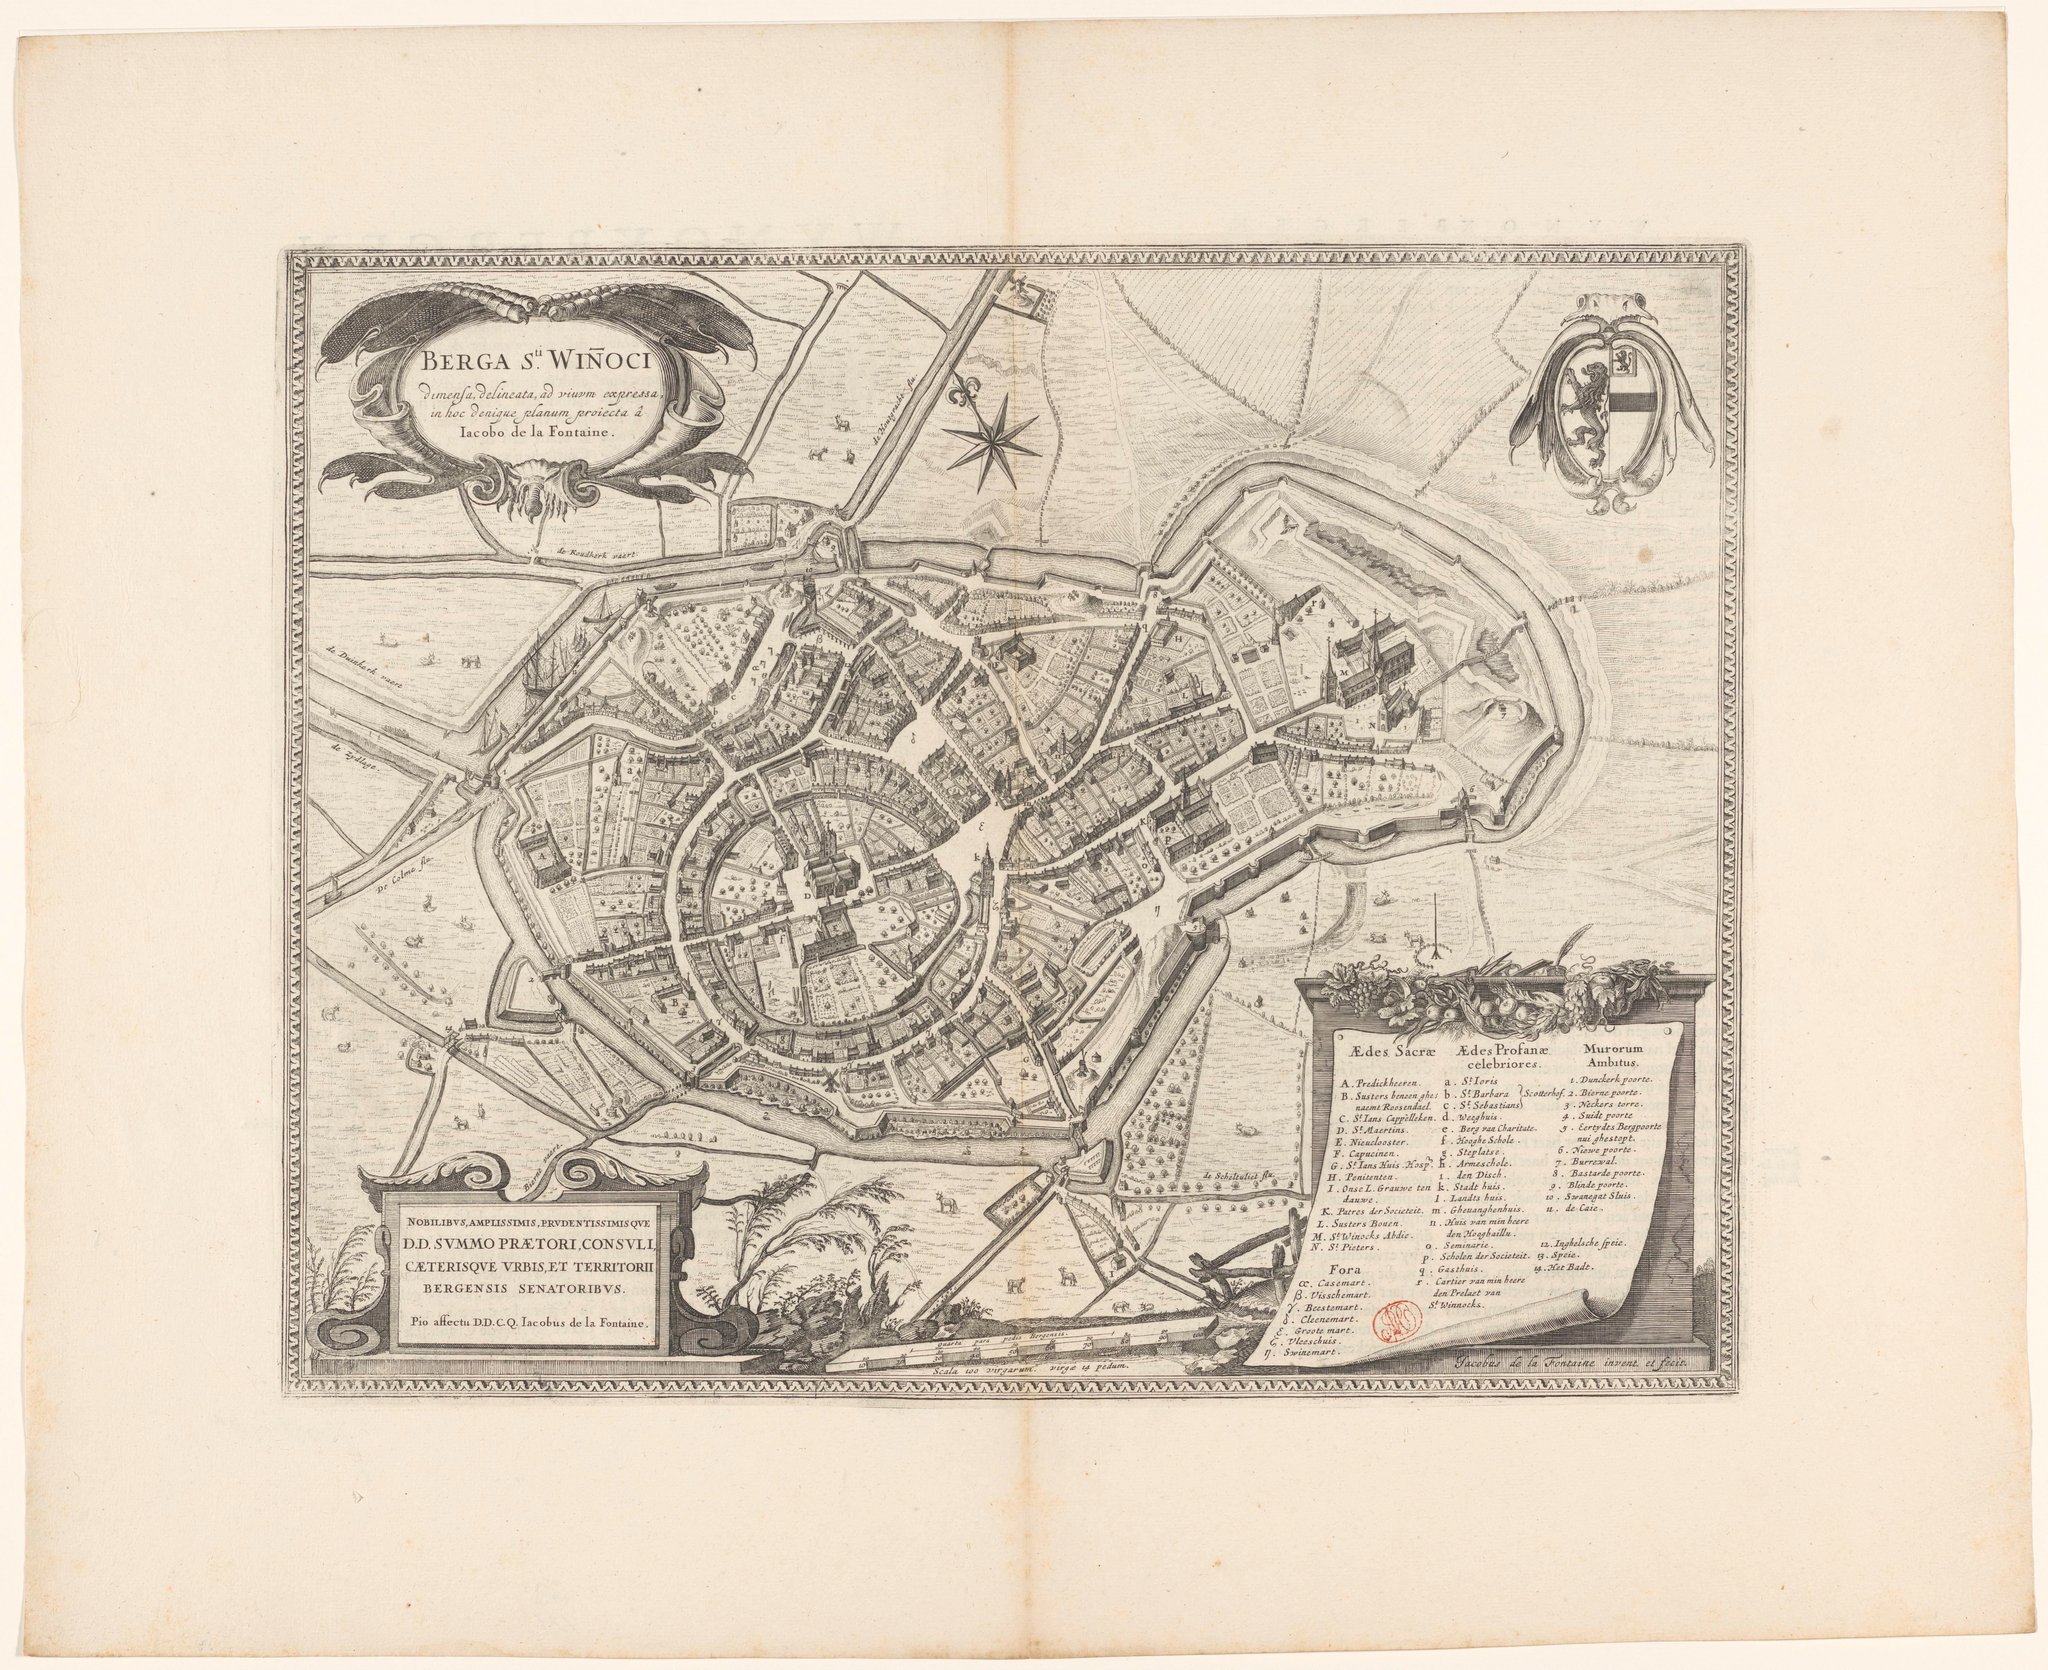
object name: print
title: Plattegrond van Sint-Winoksbergen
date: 1652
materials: paper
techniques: engraving, etching, letterpress printing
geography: sint-winoksbergen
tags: maps of separate countries or regions, coat of arms (as symbol of the state, etc.) (+ province; provincial)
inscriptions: collector's mark: Lugt 195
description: Plattegrond van Sint-Winoksbergen, ook wel Bergen genoemd, met gebouwen in vogelvluchtperspectief. Linksboven de titelcartouche. Rechtsboven het wapen van Sint-Winoksbergen. Linksonder een cartouche met opdracht. Rechtsonder een uitgebreide legenda in de vorm van een blad papier. Onder, in het midden, twee schaalstokken: Quarta pars pedis Bergensis / Scala 100 virgarum. virgae 14 pedum. De plattegrond is omlijst. Met Nederlandse tekst op verso.